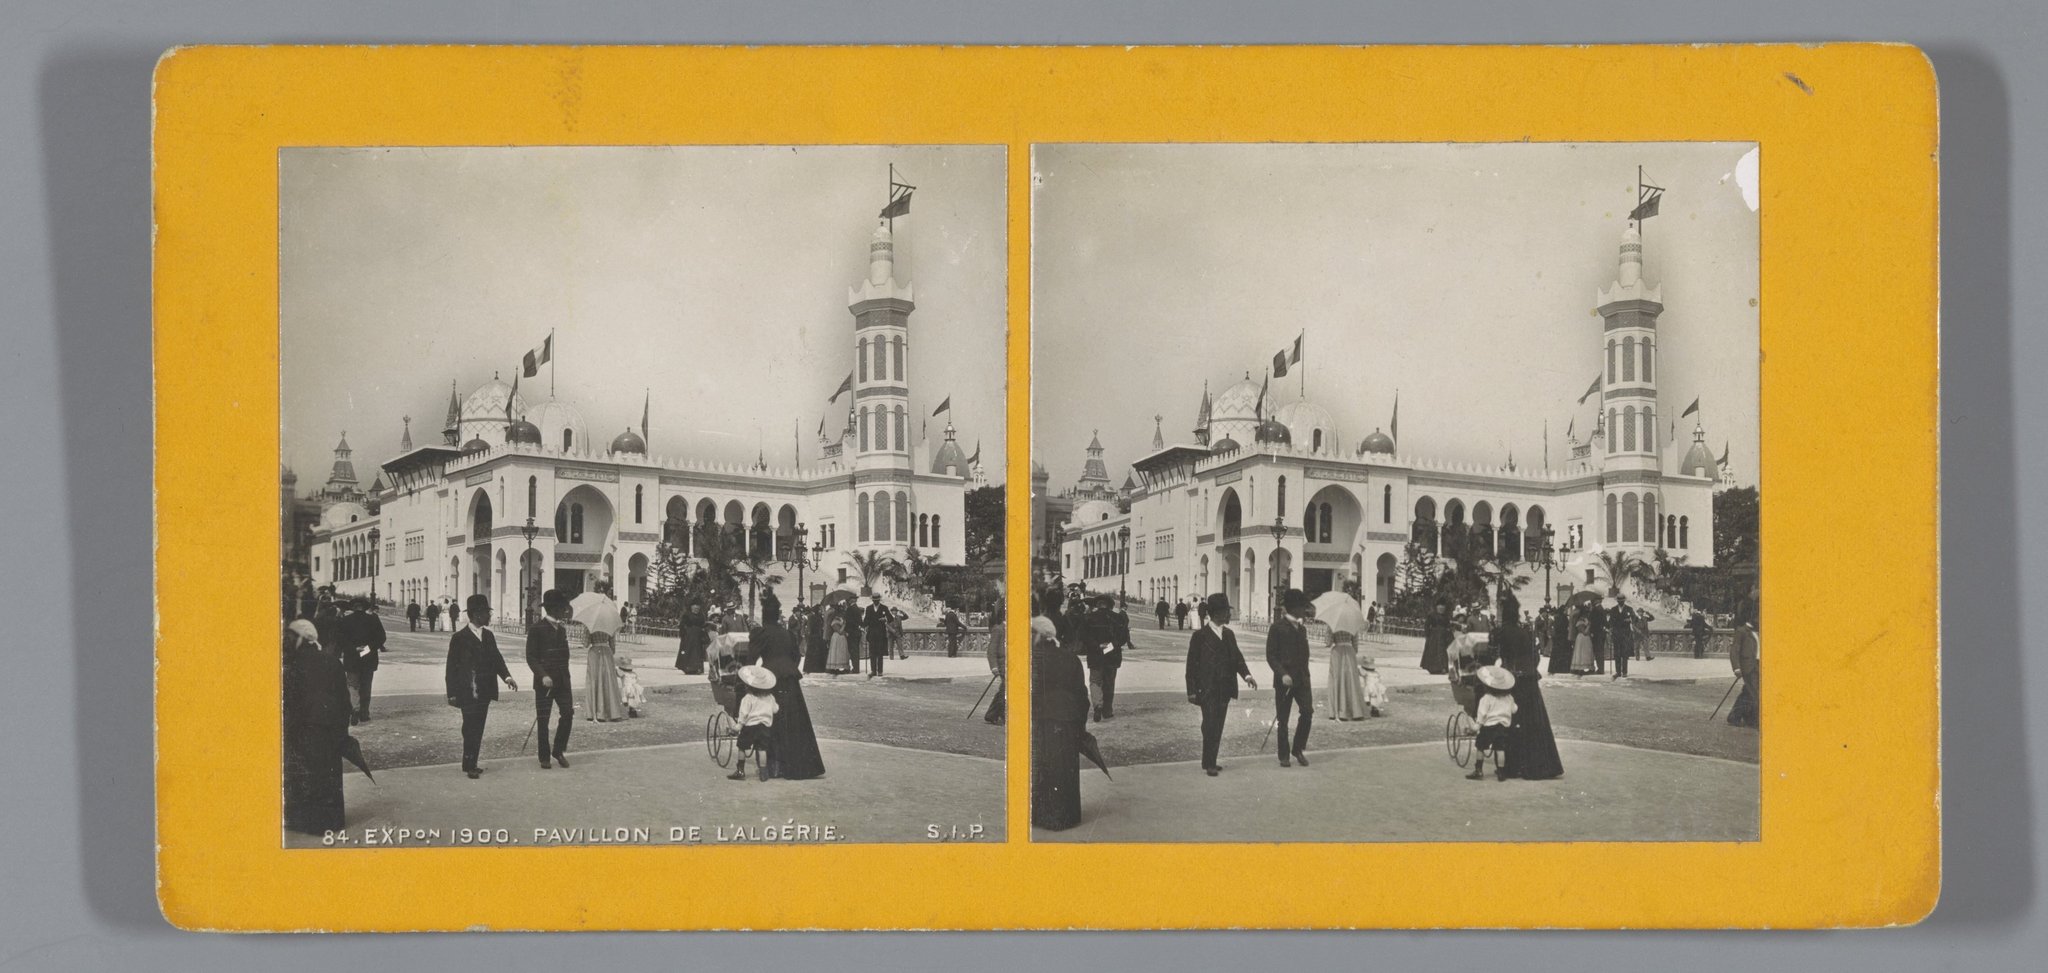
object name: stereograph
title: Expon 1900. Pavillon de l'Algérie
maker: Anonymous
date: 1900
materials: paper, cardboard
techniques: gelatin silver print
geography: rueil-malmaison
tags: world fair, world exhibition, exterior ~ representation of a building, paris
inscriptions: number: ‘84.’